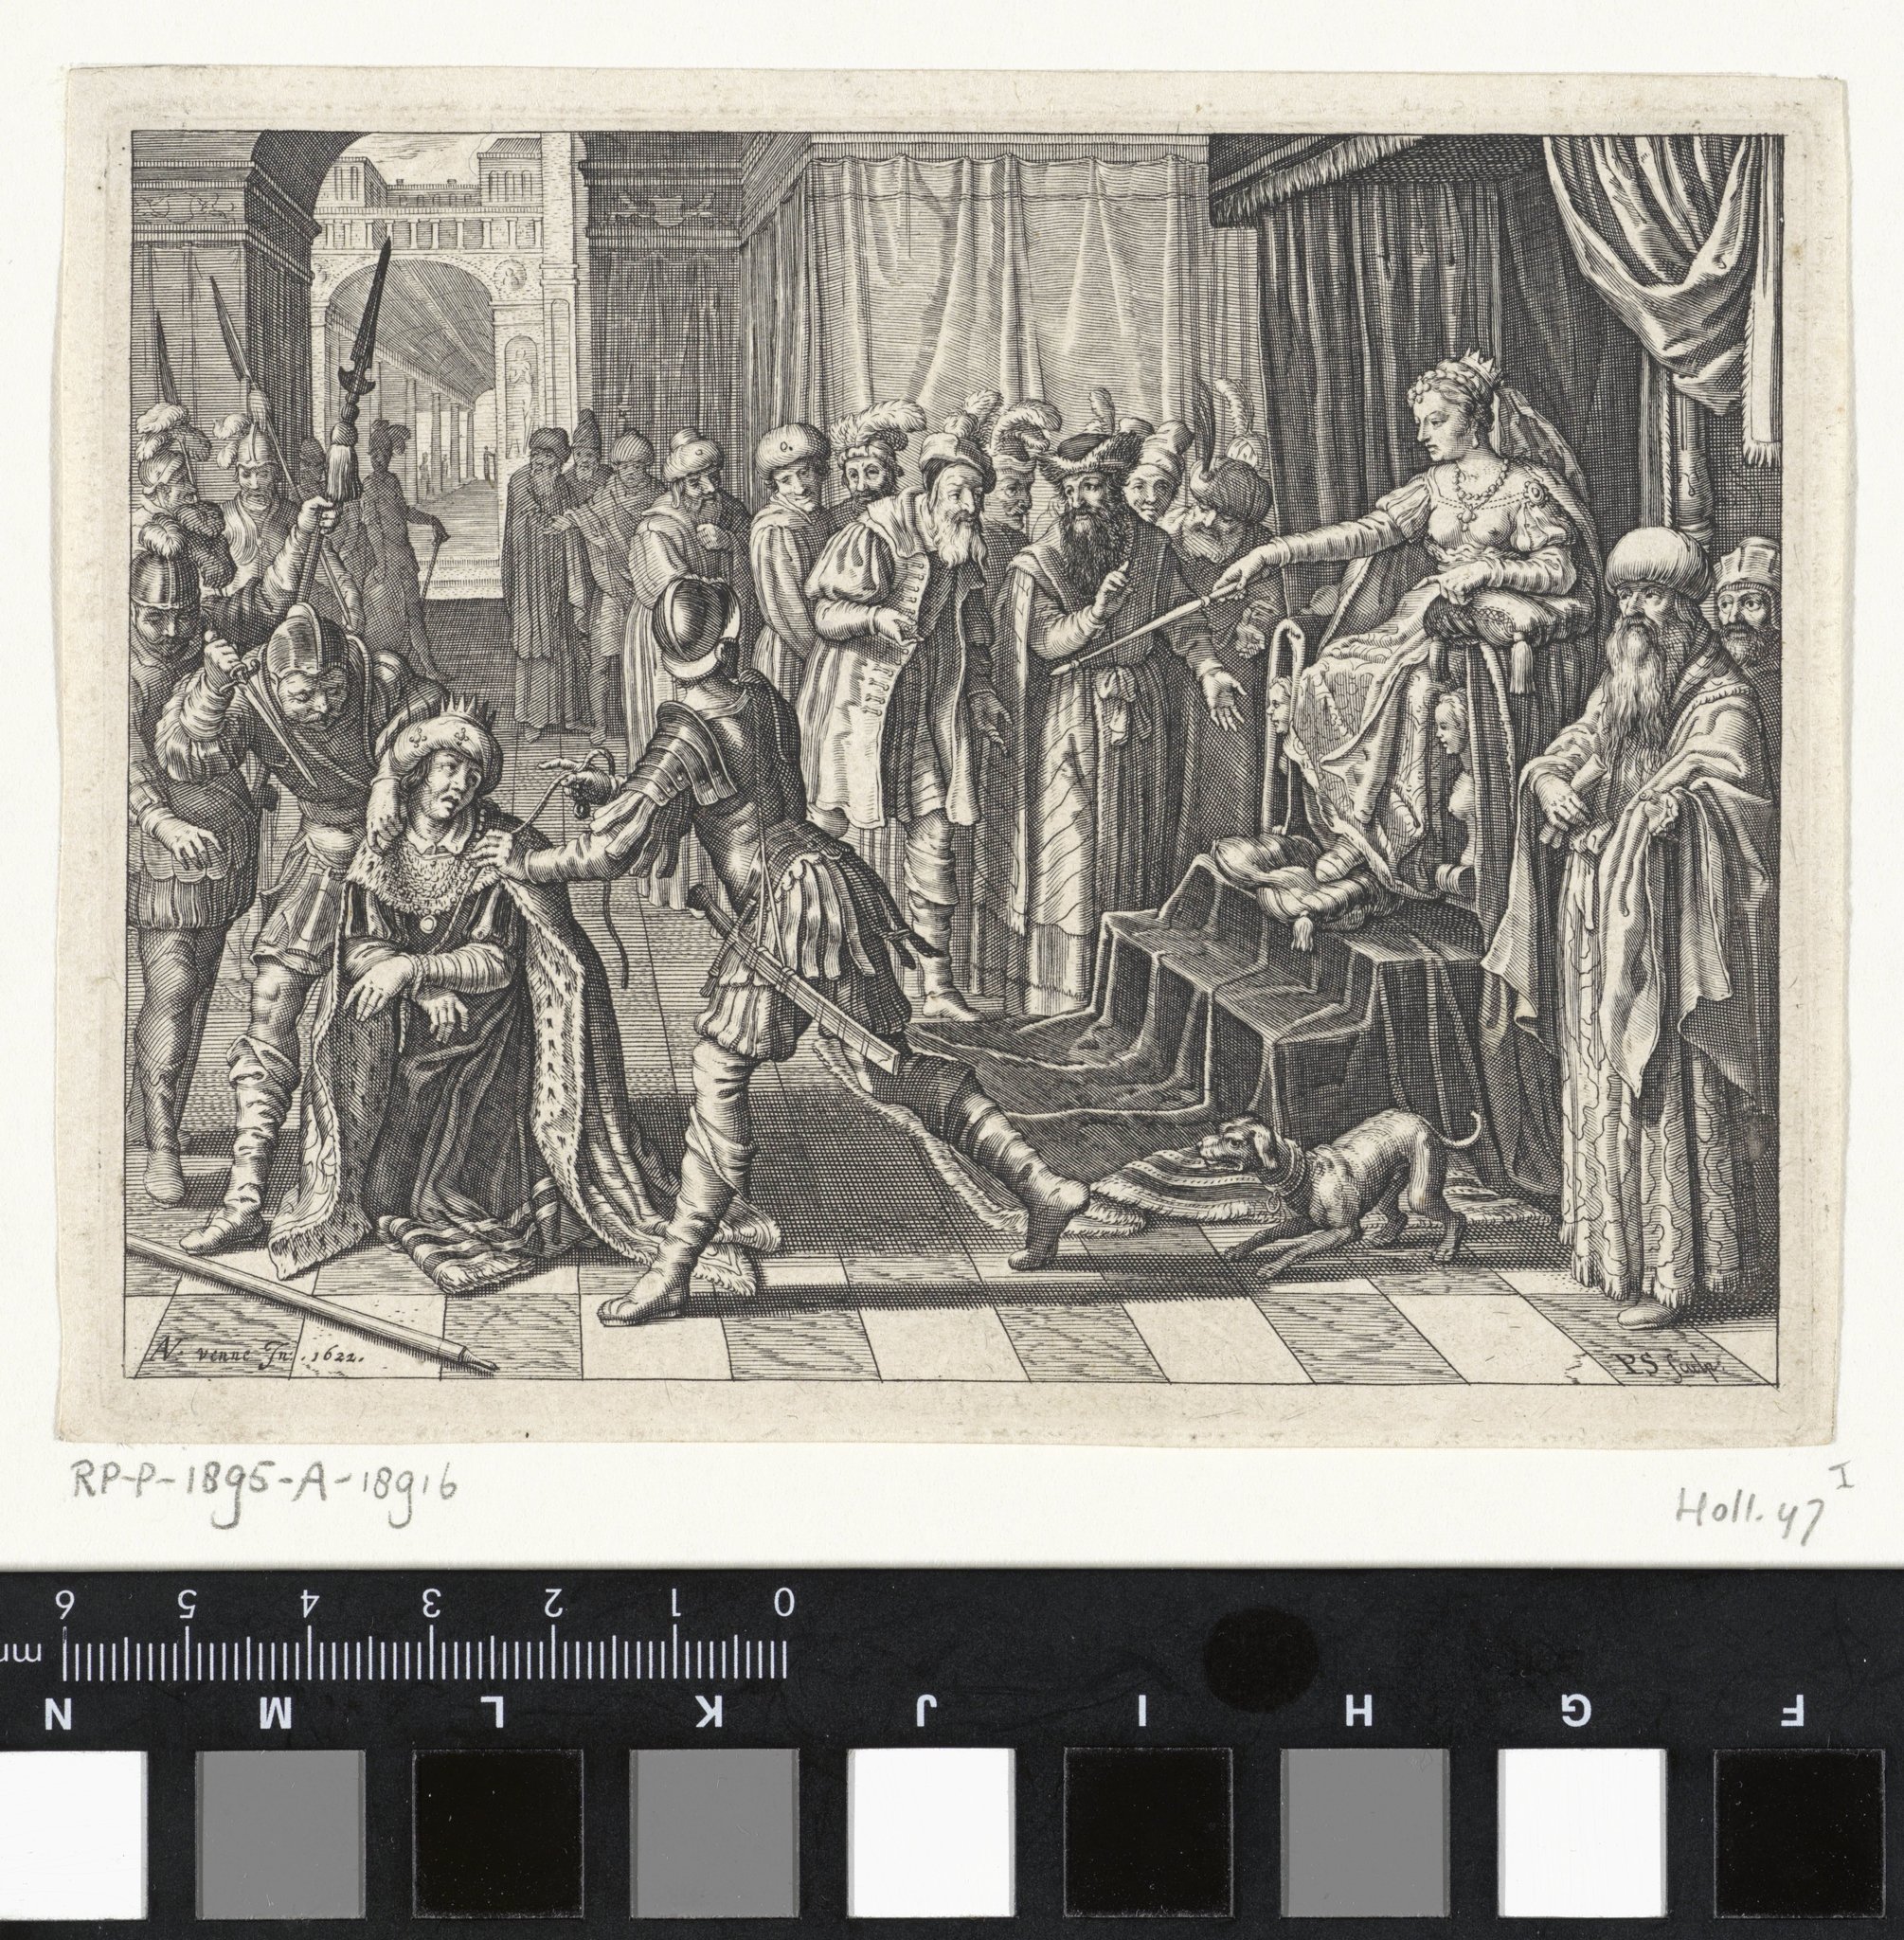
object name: print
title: koning Ninus ter dood veroordeeld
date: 1622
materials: paper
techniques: engraving, etching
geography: amsterdam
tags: (story of) queen semiramis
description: De tot koningin gemaakte maîtresse Semiramis geeft vanaf haar troon opdracht om de rechtmatige koning Ninus terecht te stellen. Een soldaat bindt zijn handen, een tweede soldaat staat klaar met een dolk in de aanslag. De hovelingen kijken vanaf de achtergrond toe.